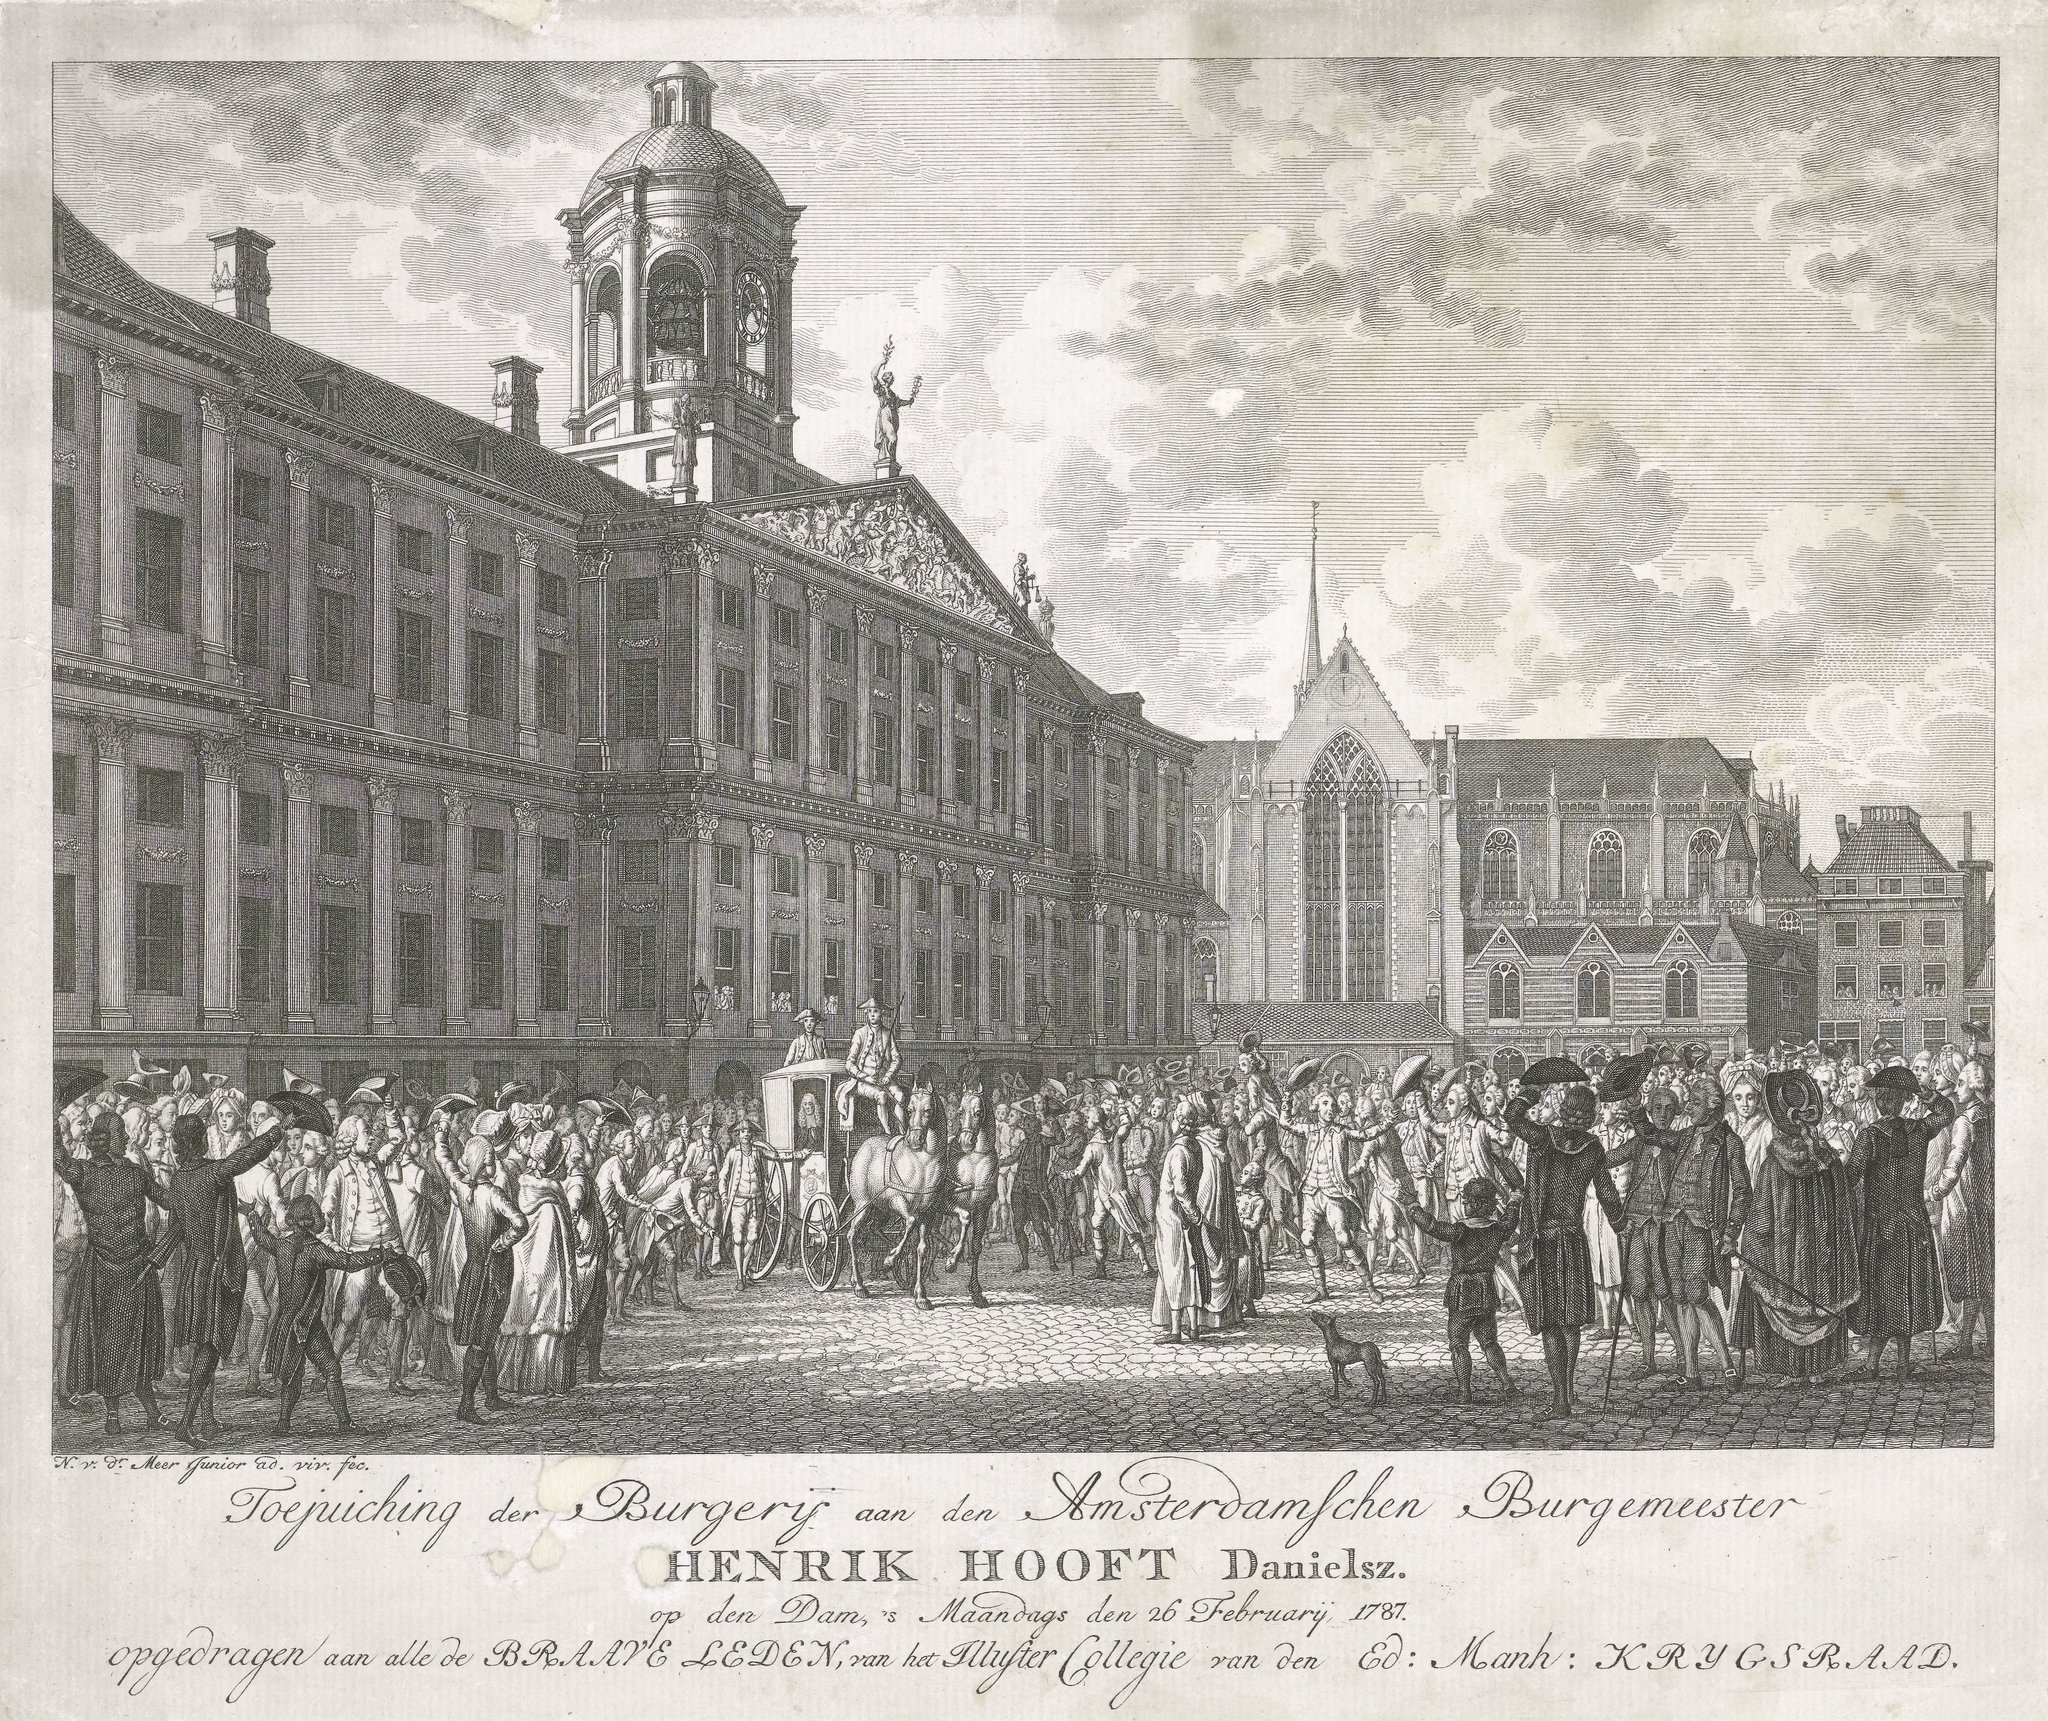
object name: print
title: Burgemeester Hendrik Danielsz. Hooft toegejuicht door de menigte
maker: noach van der meer (ii)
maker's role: draughtsman, print maker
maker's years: 1741-1822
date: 1787-1789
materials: paper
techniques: engraving, etching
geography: amsterdam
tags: amsterdam, mayor, hendrik danielsz. hooft, triumphal entry and public reception, pageant, 'entrée solennelle', 'joyeuse entrée', townhall, four-wheeled vehicle drawn by two animals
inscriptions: collector's mark: Lugt 2228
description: Hendrik Danielsz. Hooft, burgemeester van Amsterdam, gezeten in een koets toegejuicht door de burgers van de stad op 26 februari 1787 op de Dam. Links het stadhuis, op de achtergrond de Nieuwe Kerk.